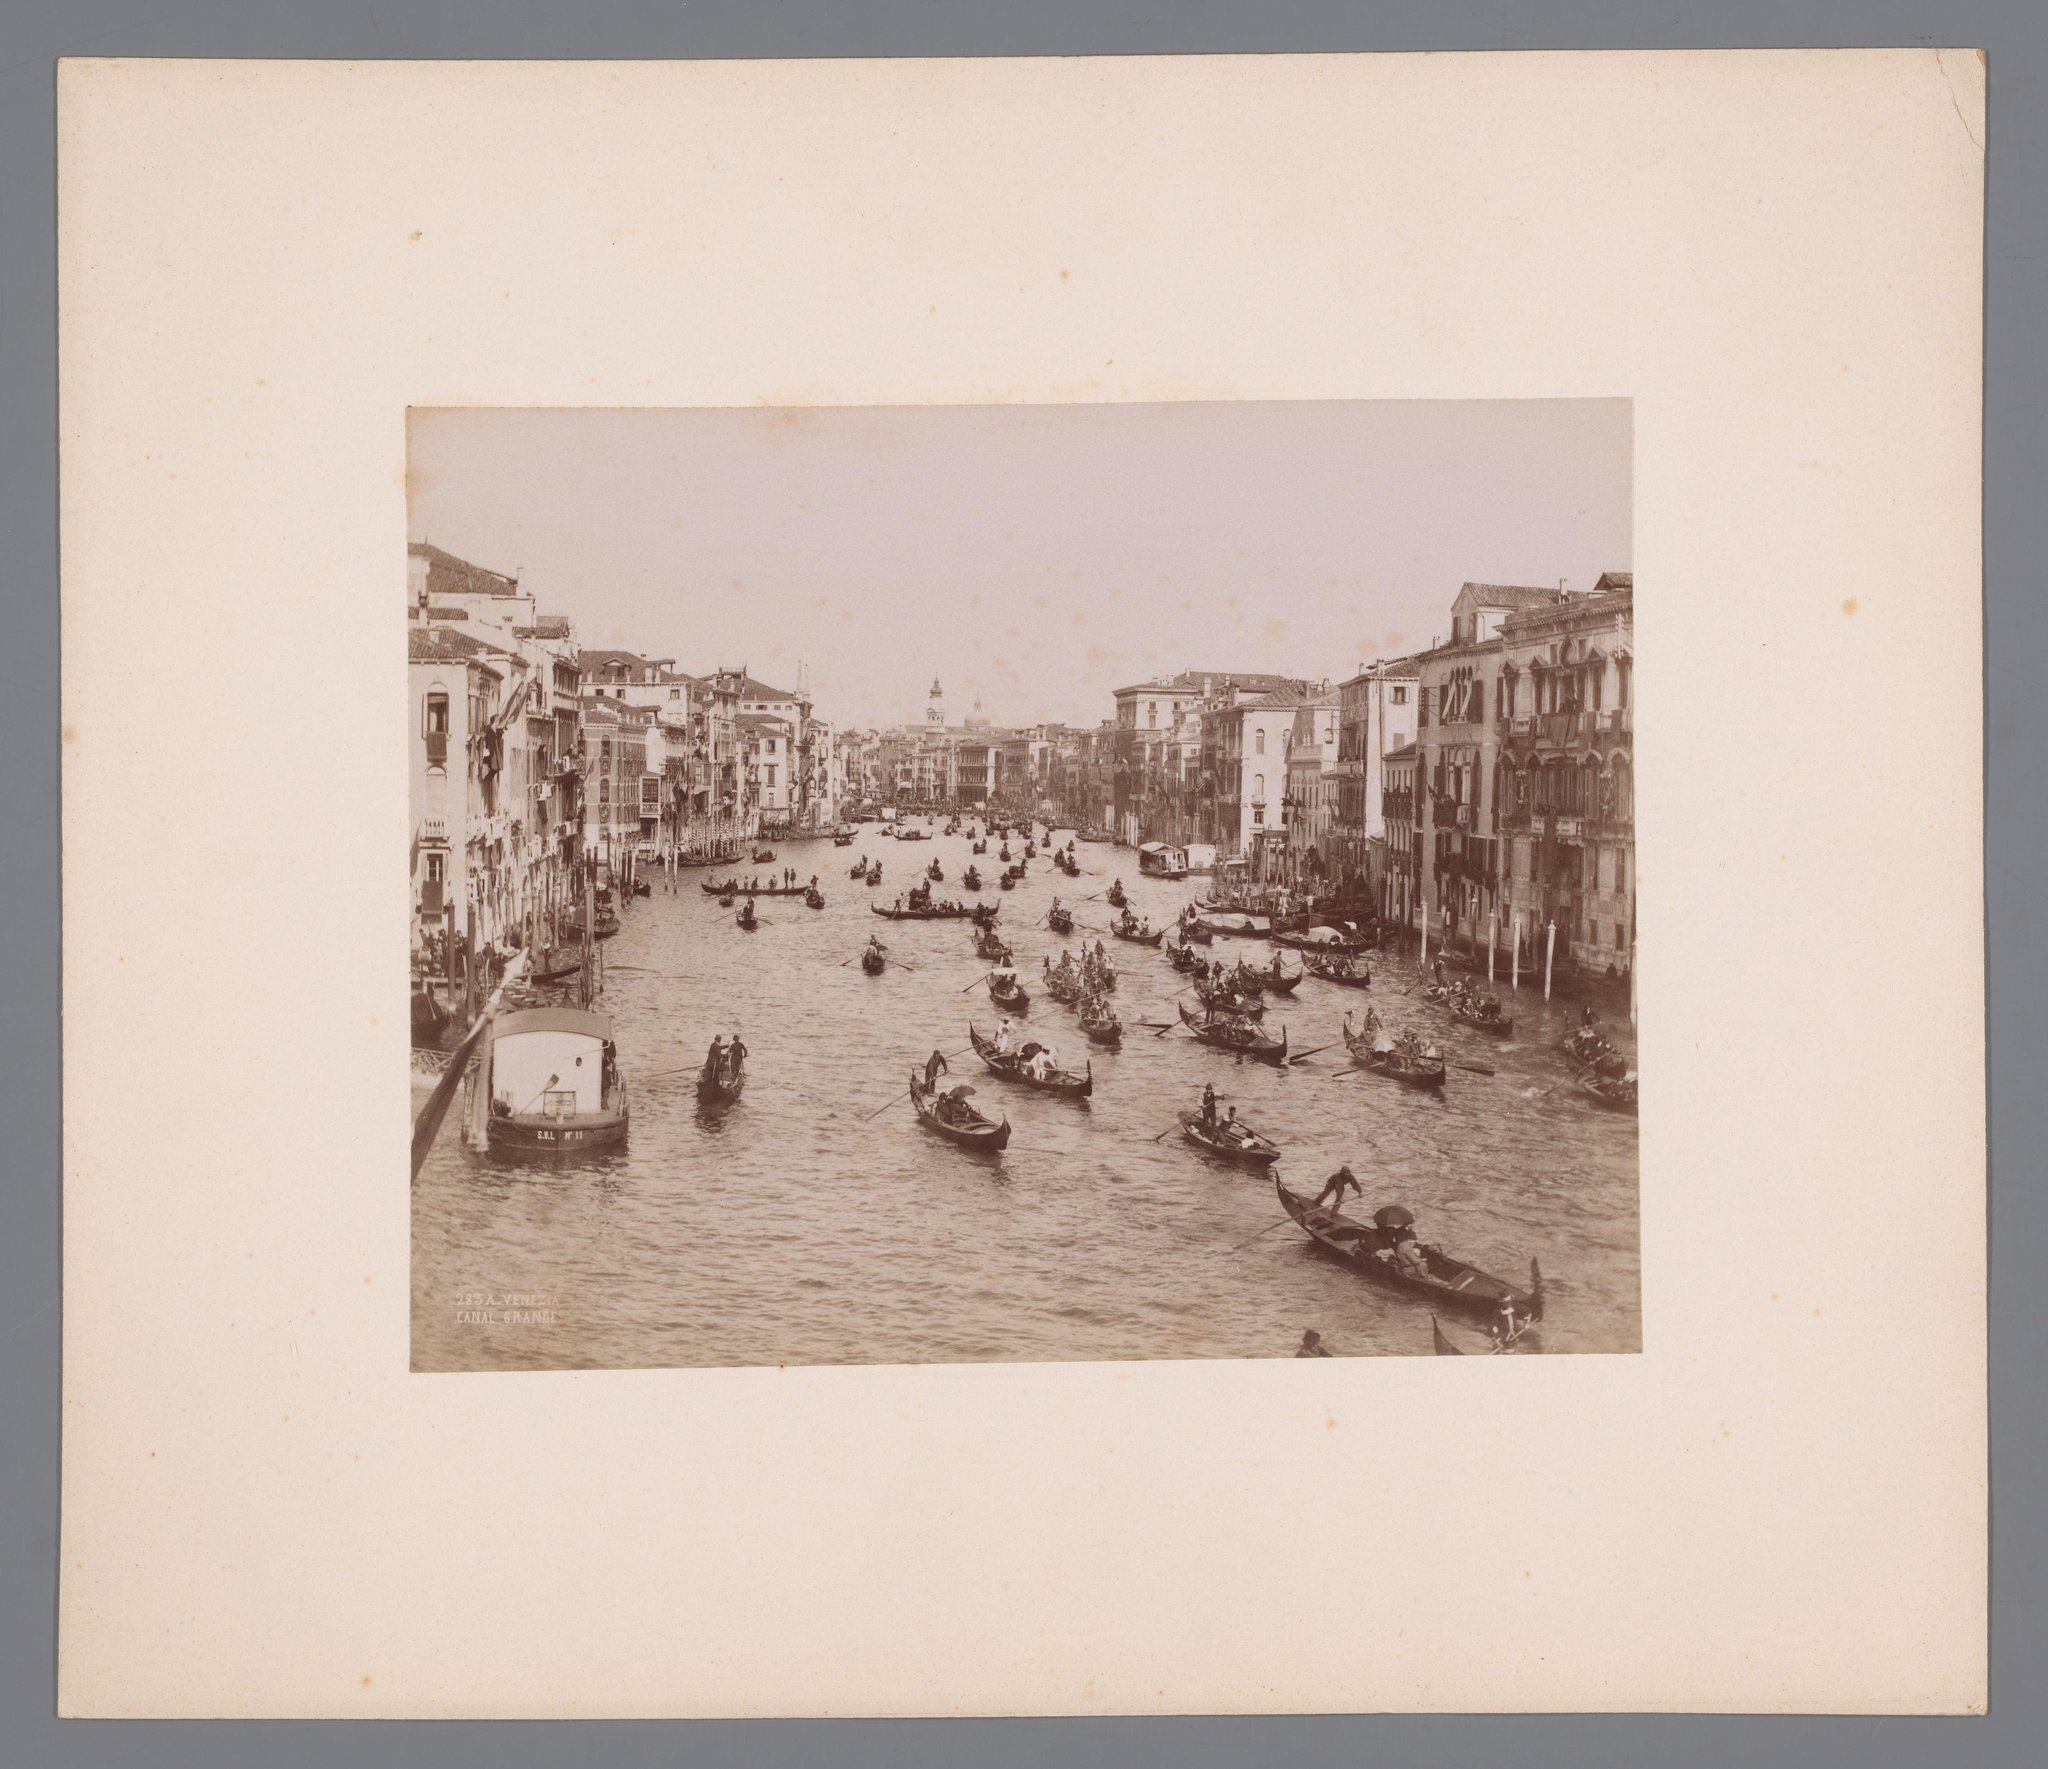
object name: photograph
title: Gondels in het Canal Grande van Venetië, Italië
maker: Anonymous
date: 1851-1900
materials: cardboard, paper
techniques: albumen print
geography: venice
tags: urban housing, canals, waters (in city), gondola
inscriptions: number: ‘283A.’